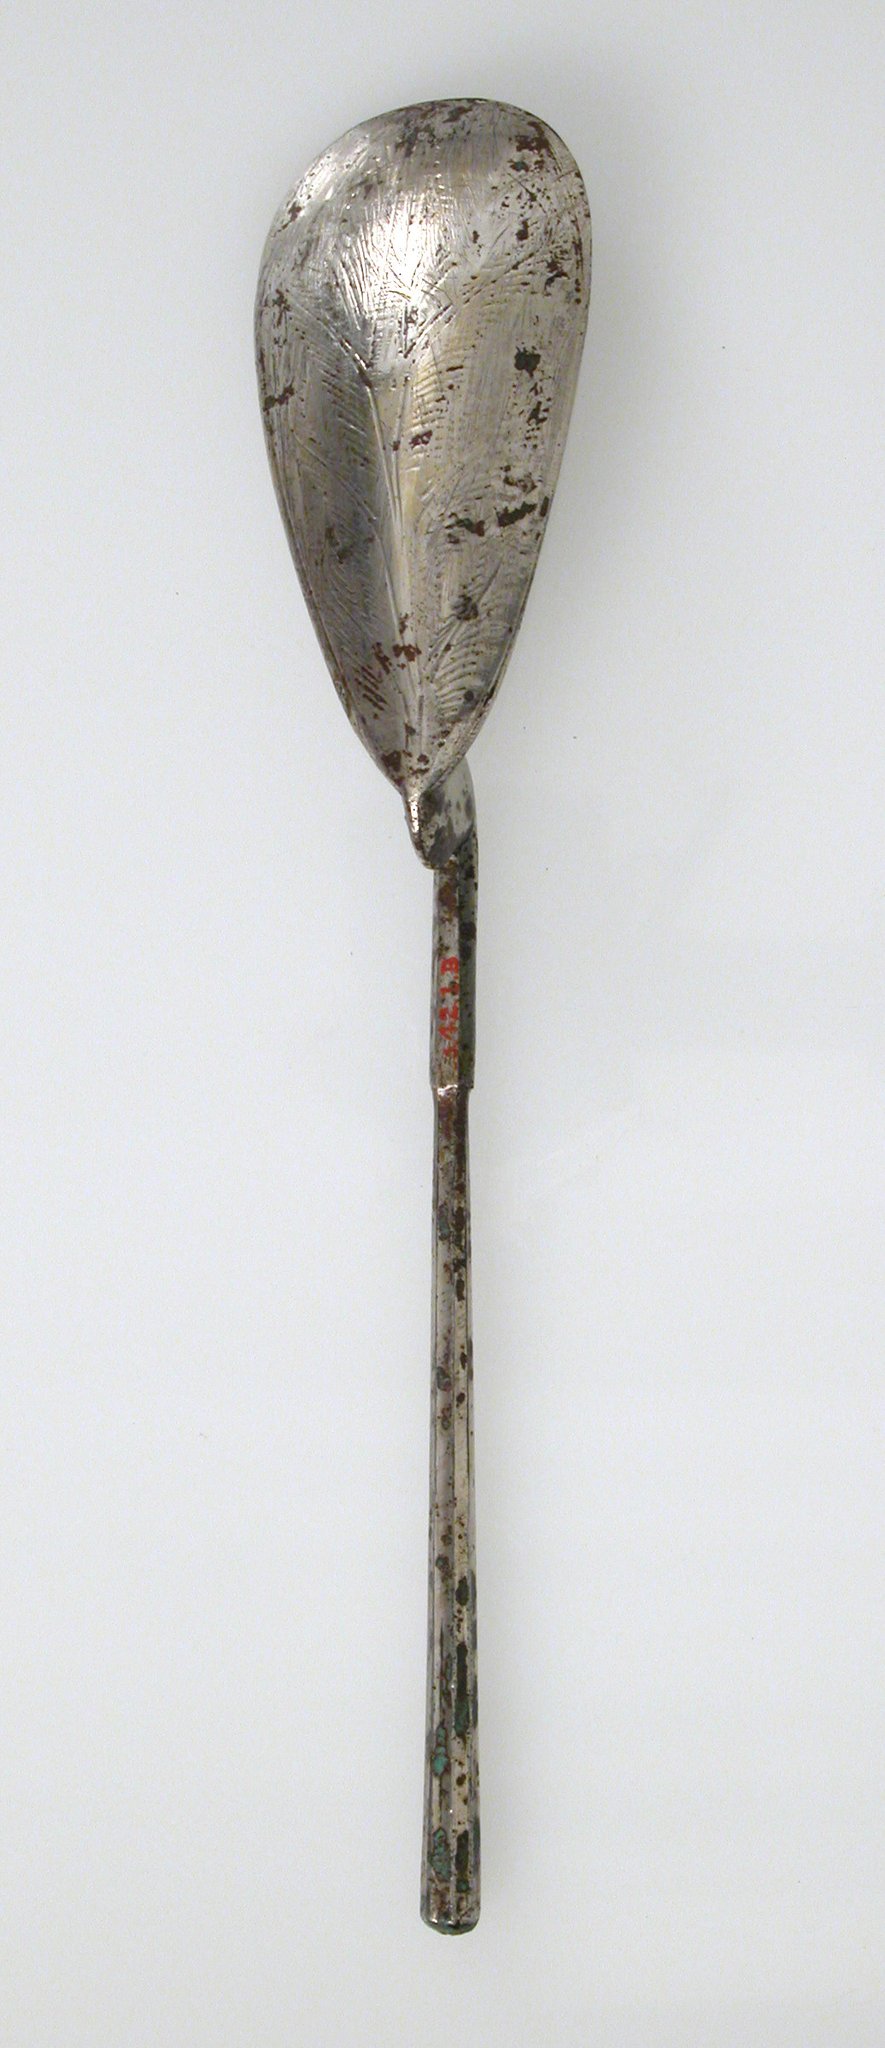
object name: spoon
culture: byzantine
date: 401-600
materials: silver